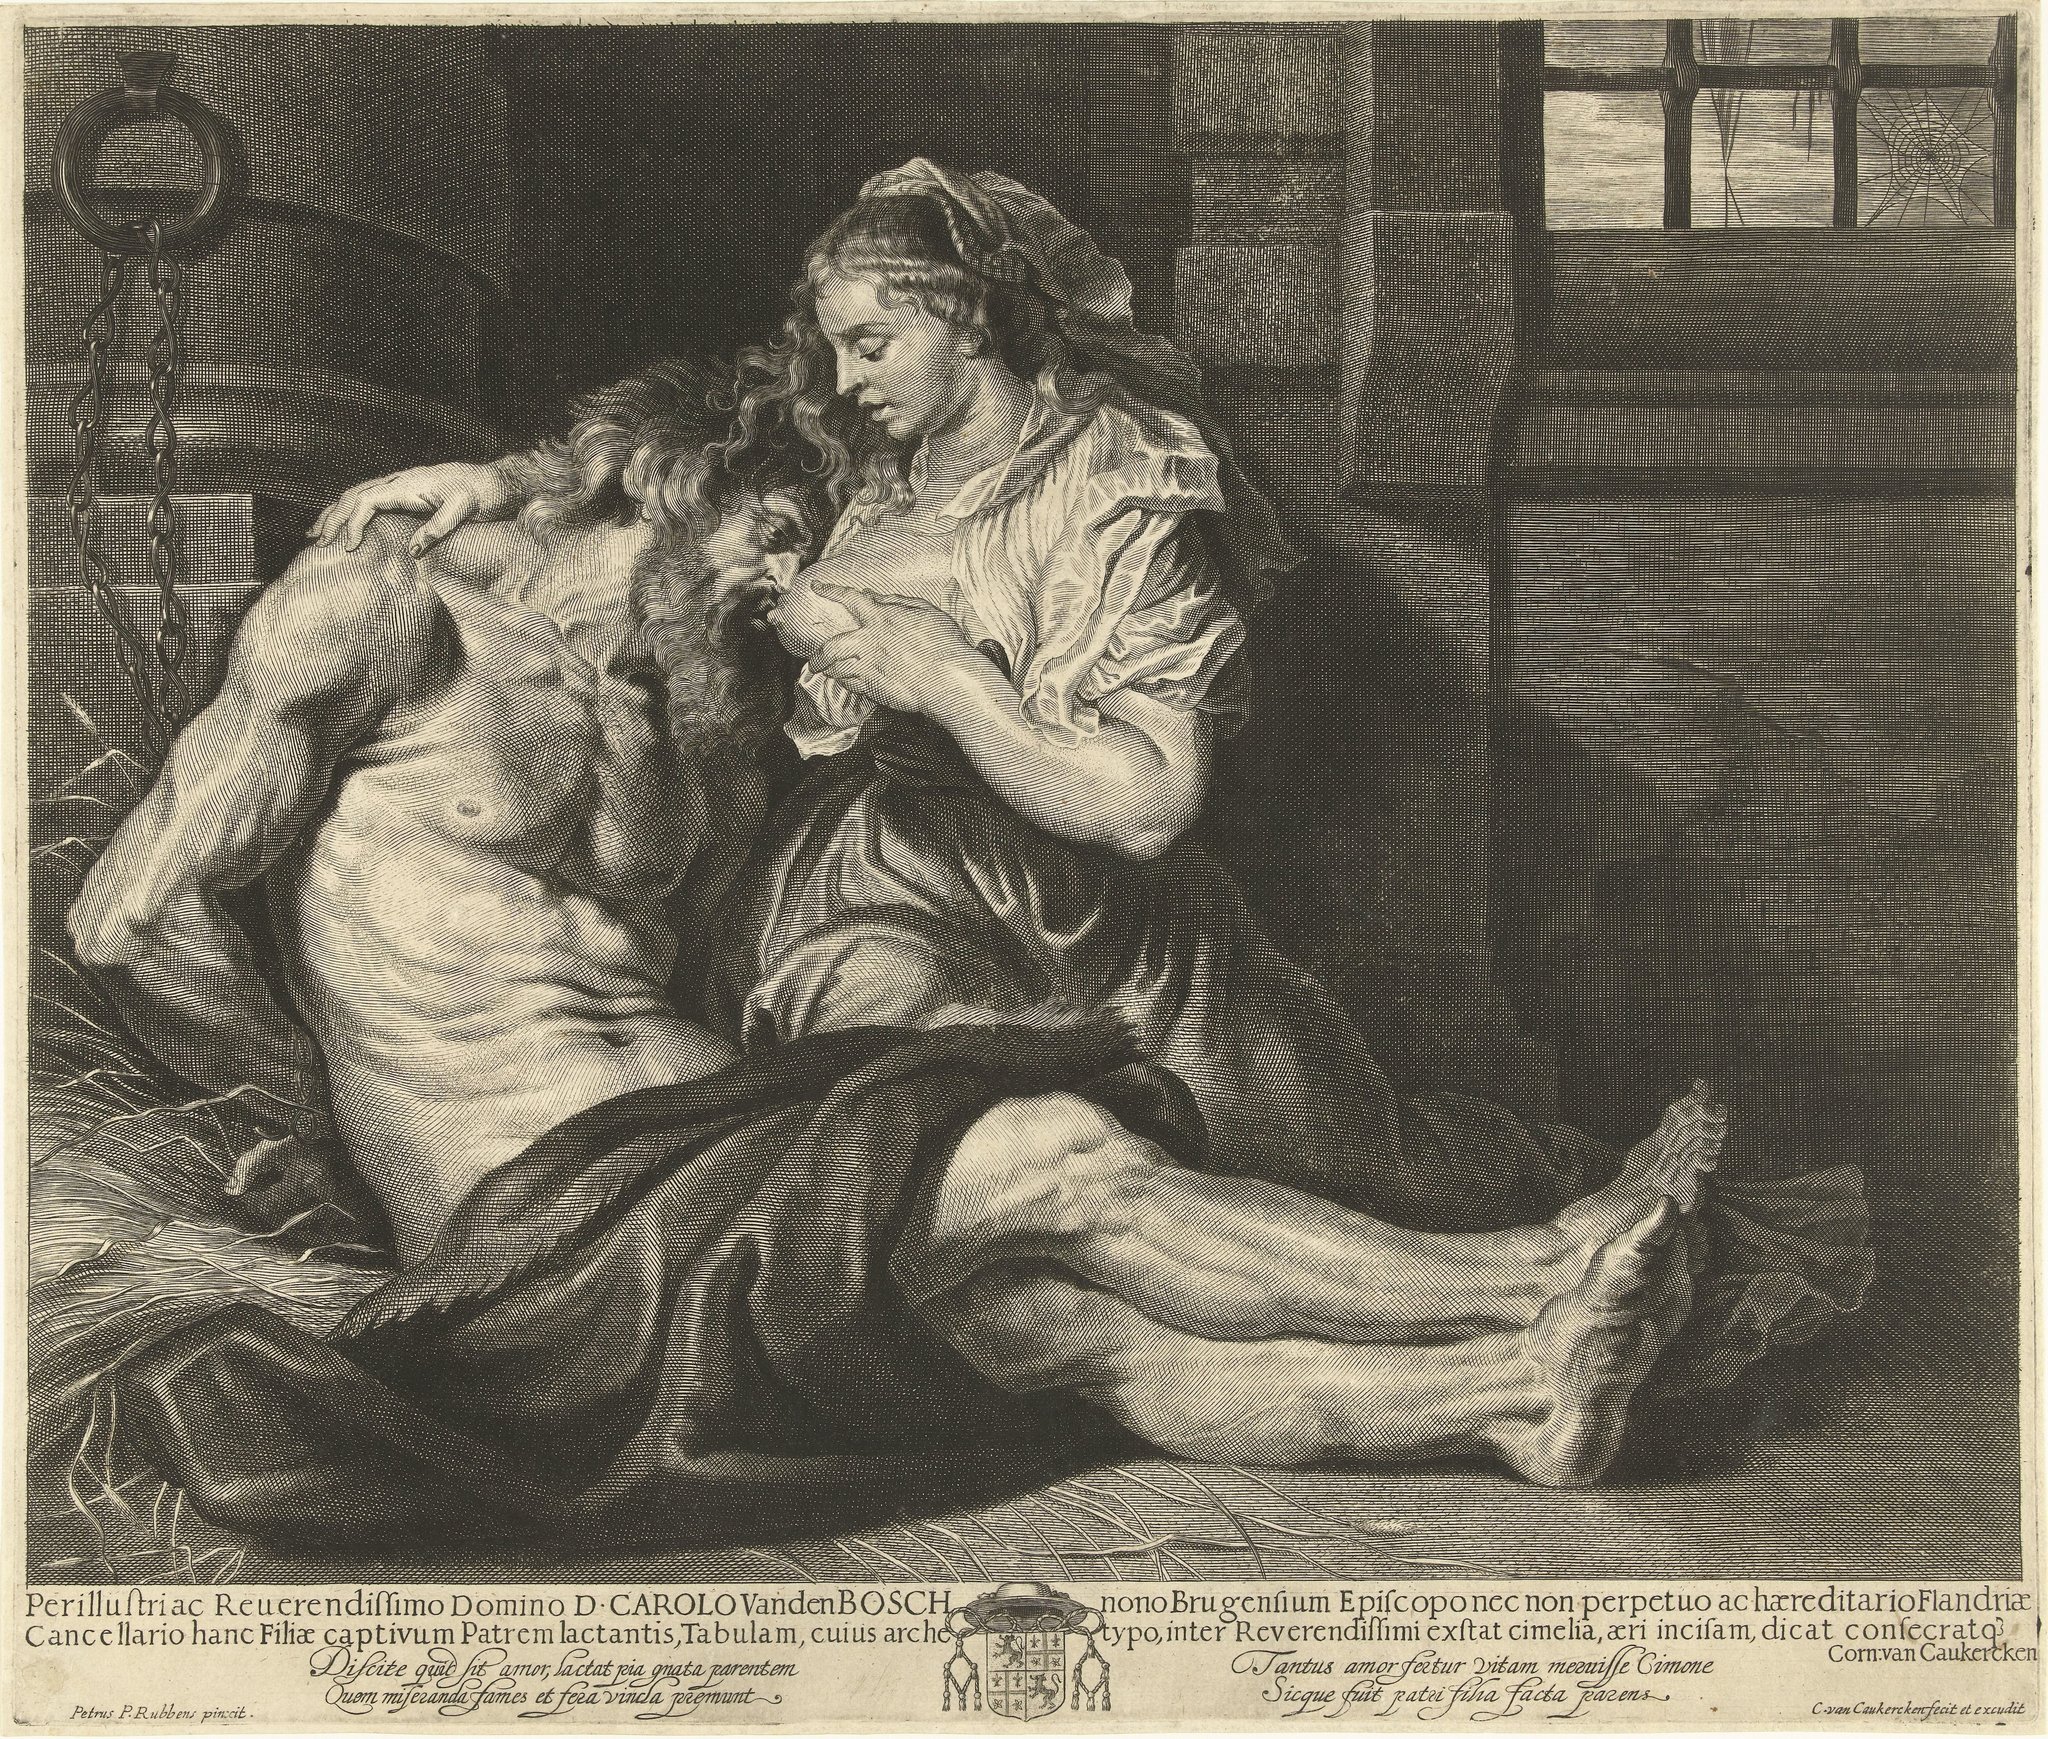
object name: print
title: Cimon en Pero (Caritas Romana)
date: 1640-1660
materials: paper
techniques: engraving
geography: southern netherlands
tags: pero suckling cimon ('caritas romana')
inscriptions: collector's mark: Lugt 240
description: Pero geeft haar vader, die geboeid in de gevangenis zit, de borst. Cimon zit op de grond in het stro een doek om zijn middel geslagen. Rechts een getralied raam. Onder de voorstelling het wapen schild van en een opdracht in het Latijn aan bisschop Karel van den Bosch.